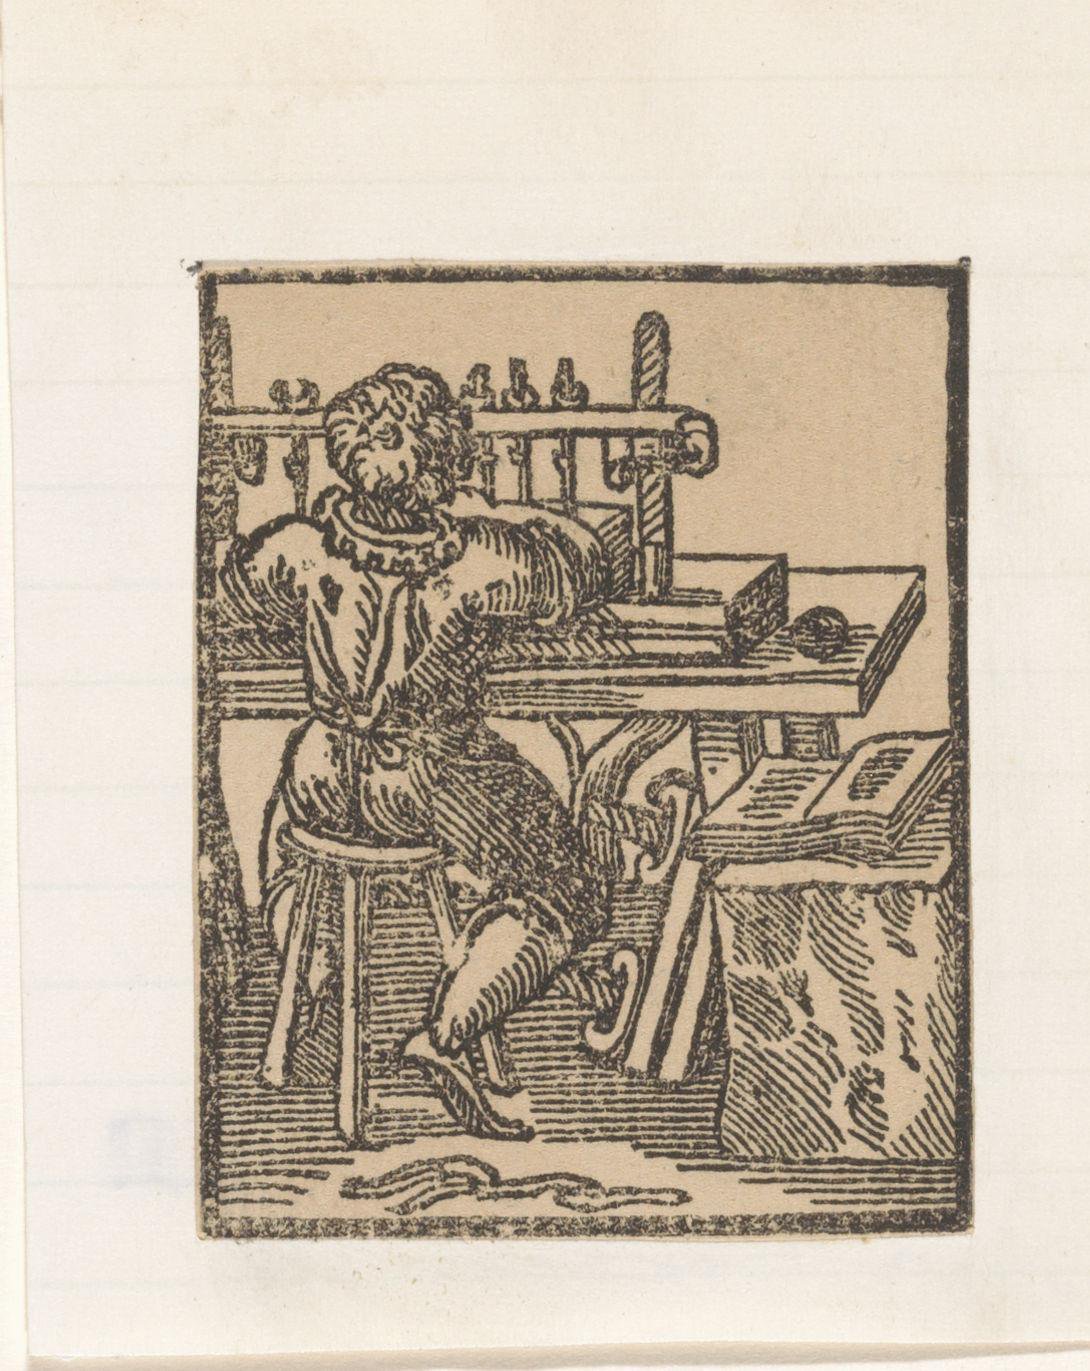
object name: print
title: Boekbinder achter zijn werktafel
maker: Anonymous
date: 1600-1900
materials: paper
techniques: woodcut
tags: bookbinding, handicrafts, craftsman at work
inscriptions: collector's mark: Lugt 2228, collector's mark: Lugt 4780, collector's mark: Lugt 4779